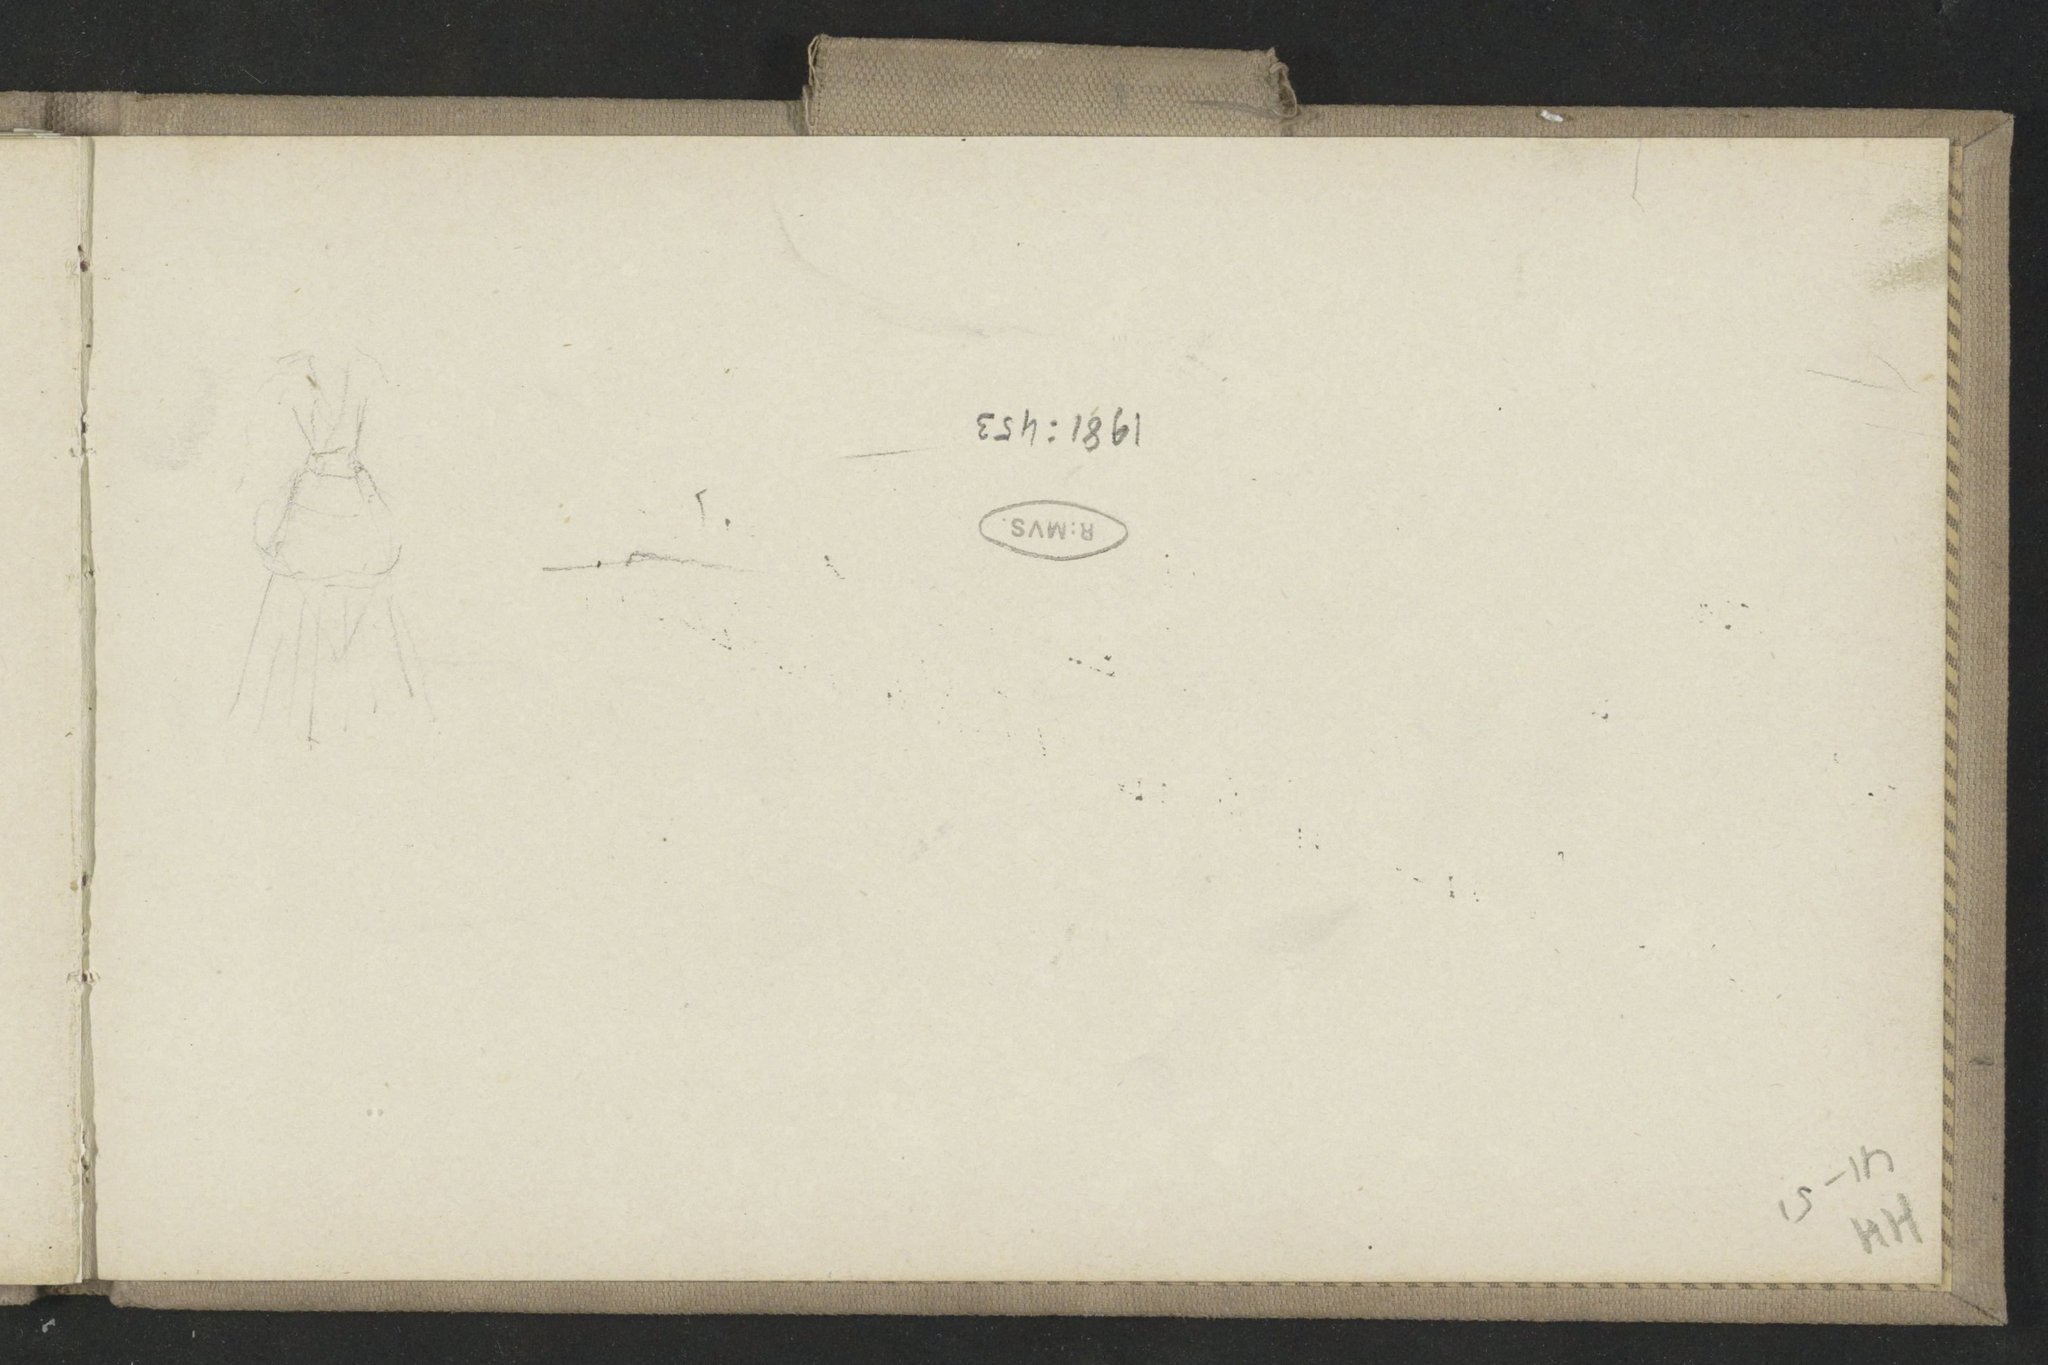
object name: endleaf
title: Studie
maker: jozef israëls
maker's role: draughtsman, painter, print maker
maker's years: 1824-1911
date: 1834-1911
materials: paper, pencil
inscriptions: collector's mark: Lugt 2228a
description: Recto-zijde van het achterste schutblad uit een schetsboek met 26 bladen.